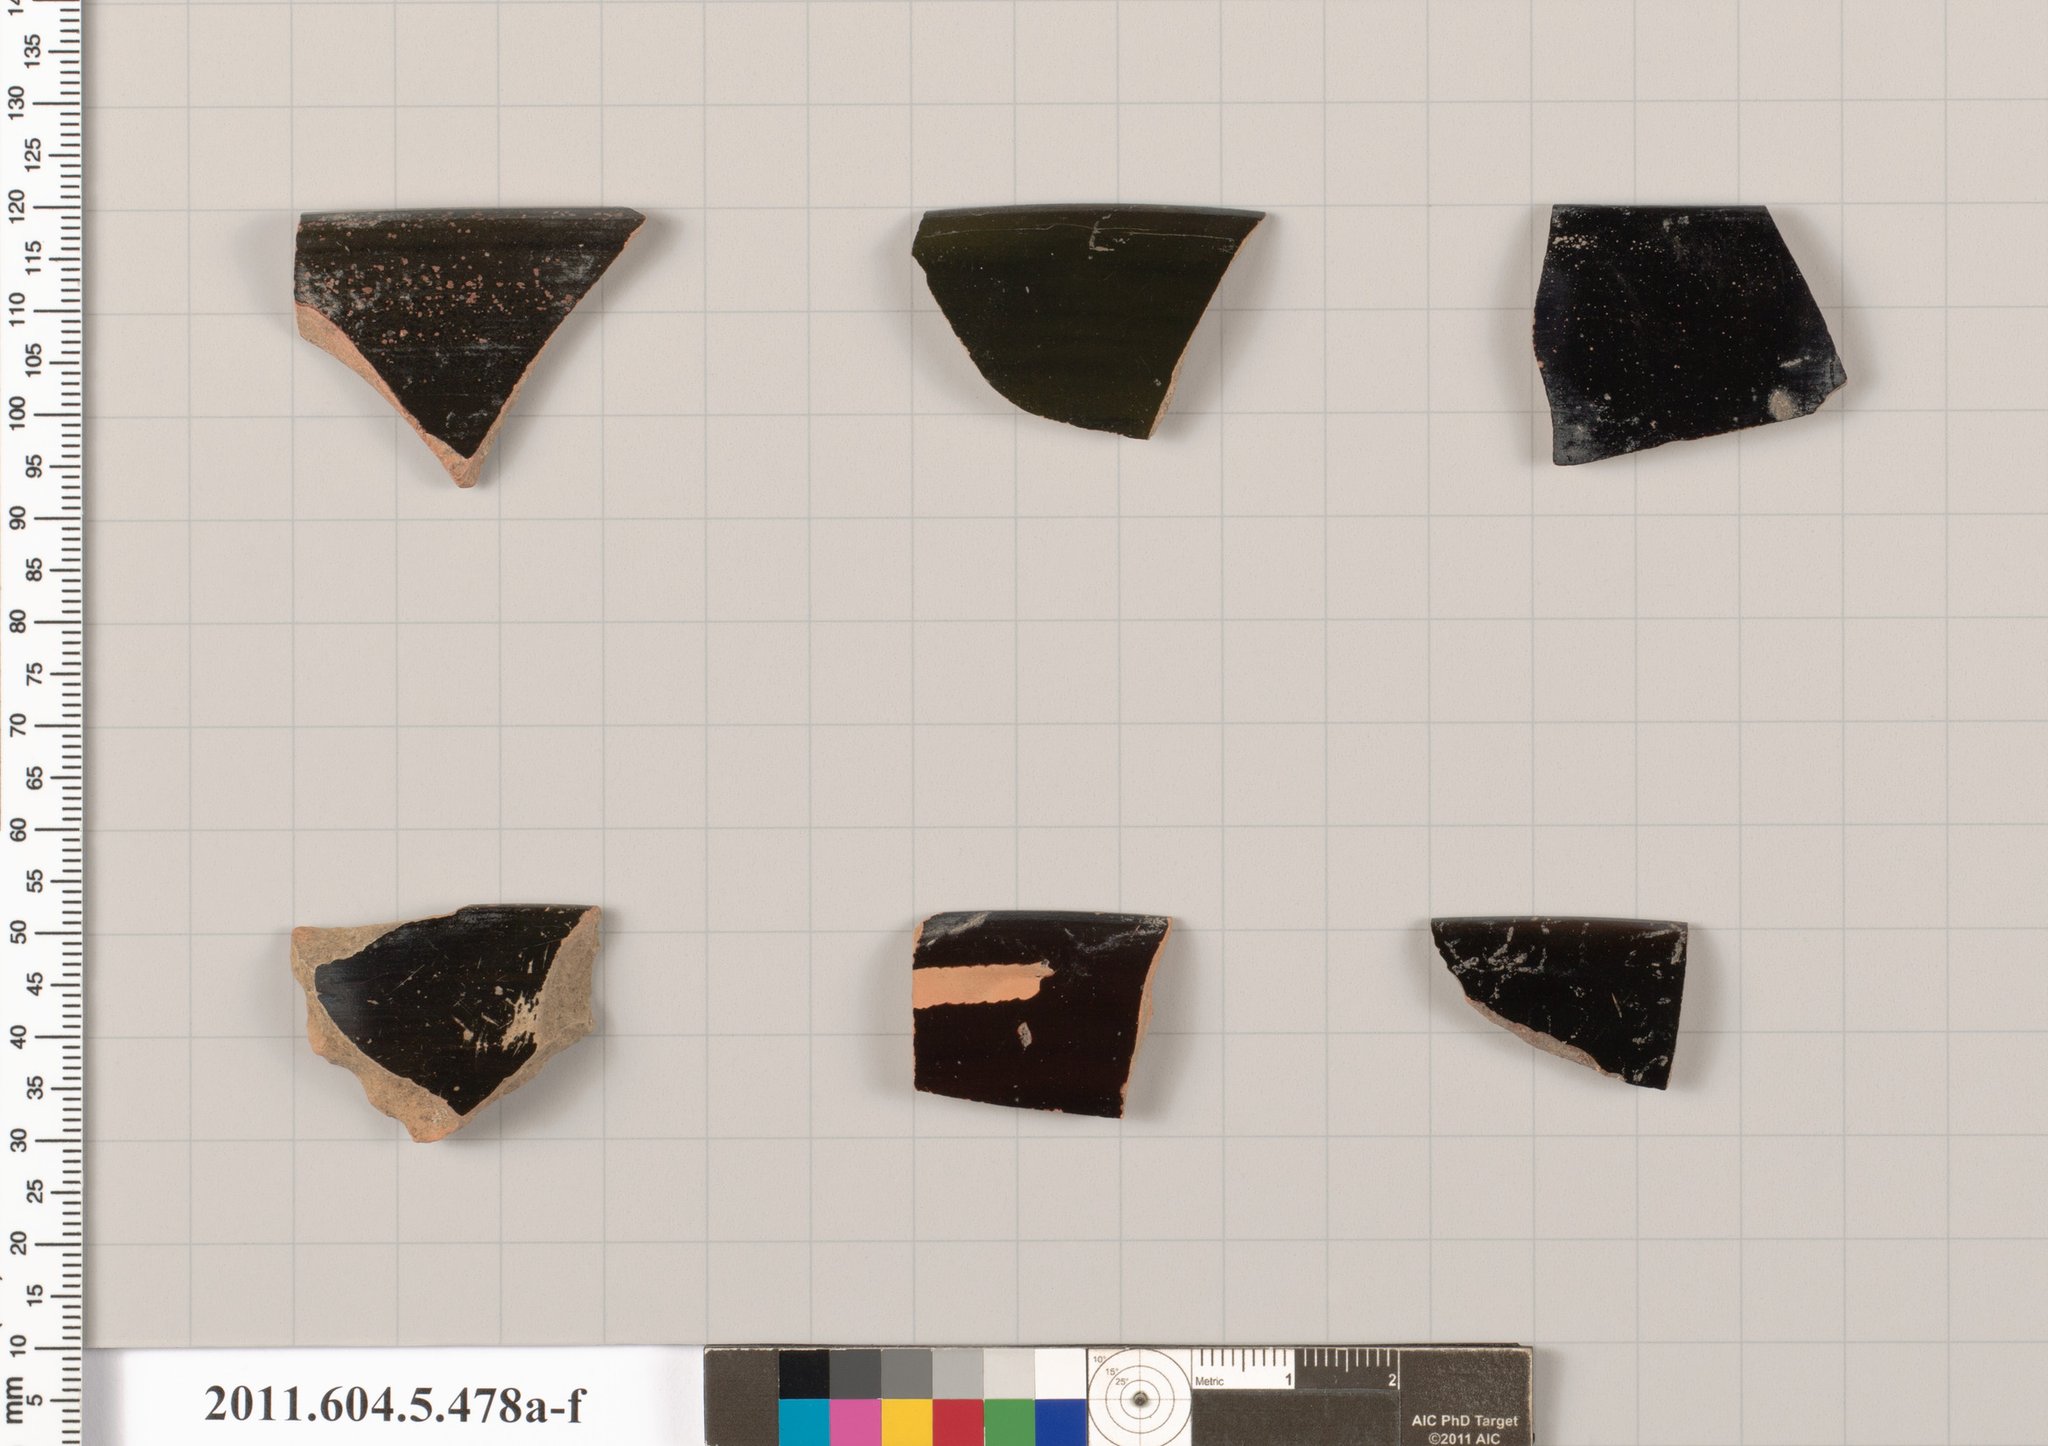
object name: kylix fragment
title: Terracotta rim fragments of kylikes (drinking cups)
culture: greek, attic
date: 600-401 BCE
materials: terracotta